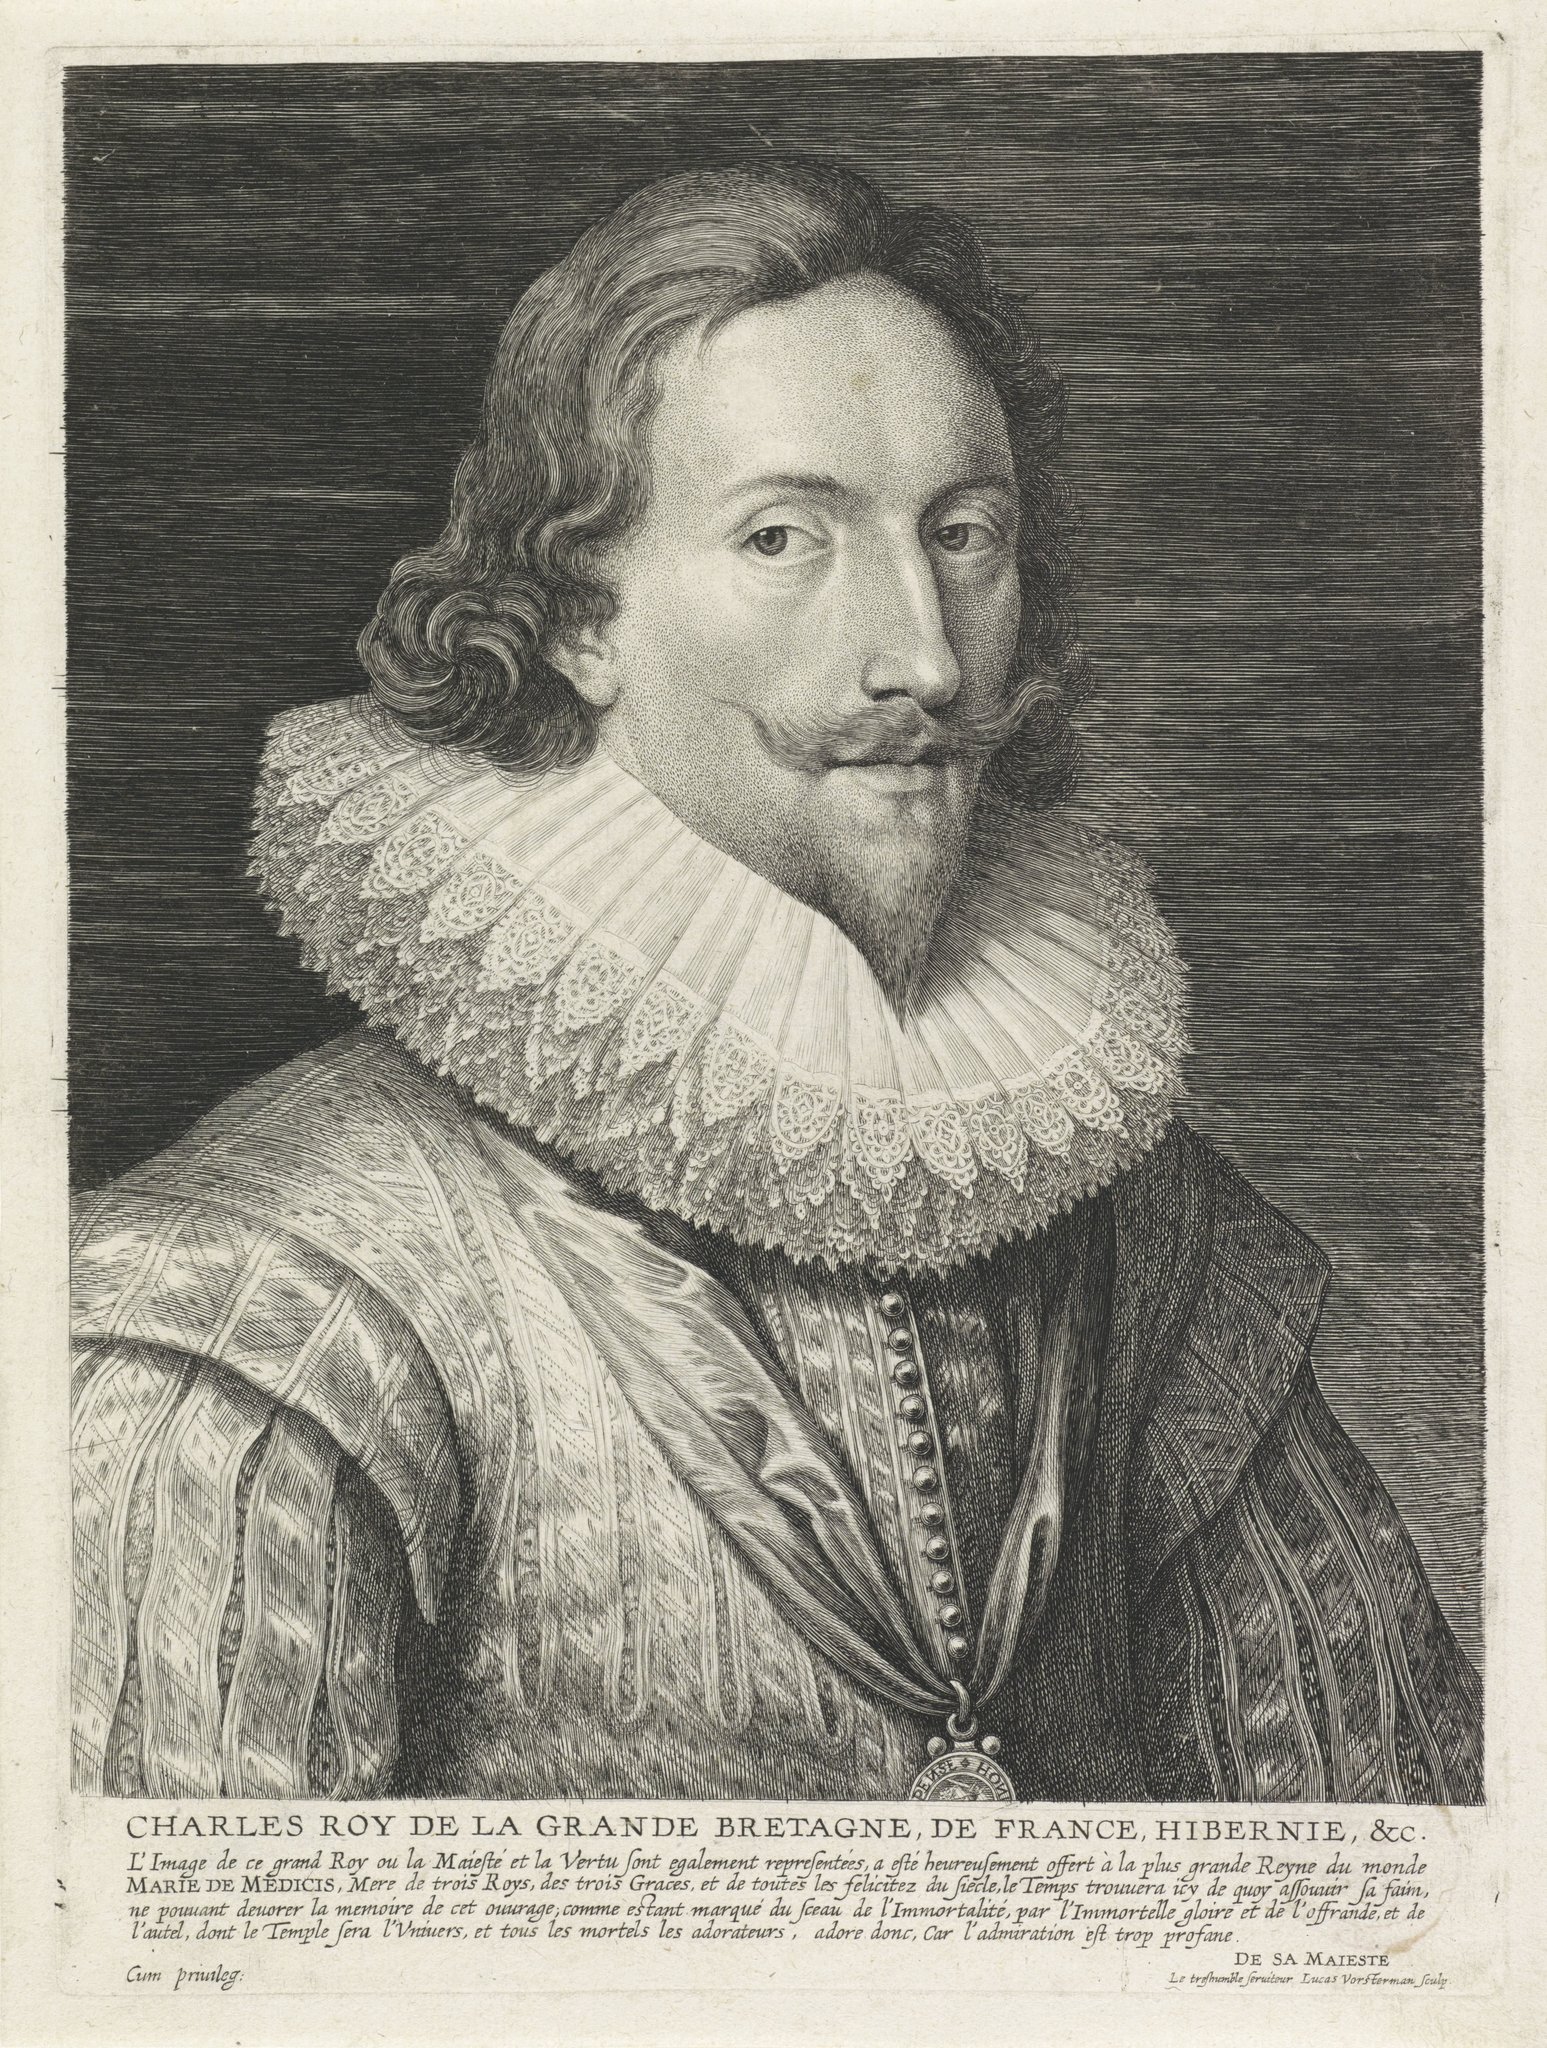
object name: print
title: Portret van Karel I, koning van Engeland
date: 1625-1642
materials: paper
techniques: engraving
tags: london, karel i (koning van engeland)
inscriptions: collector's mark: Lugt 240